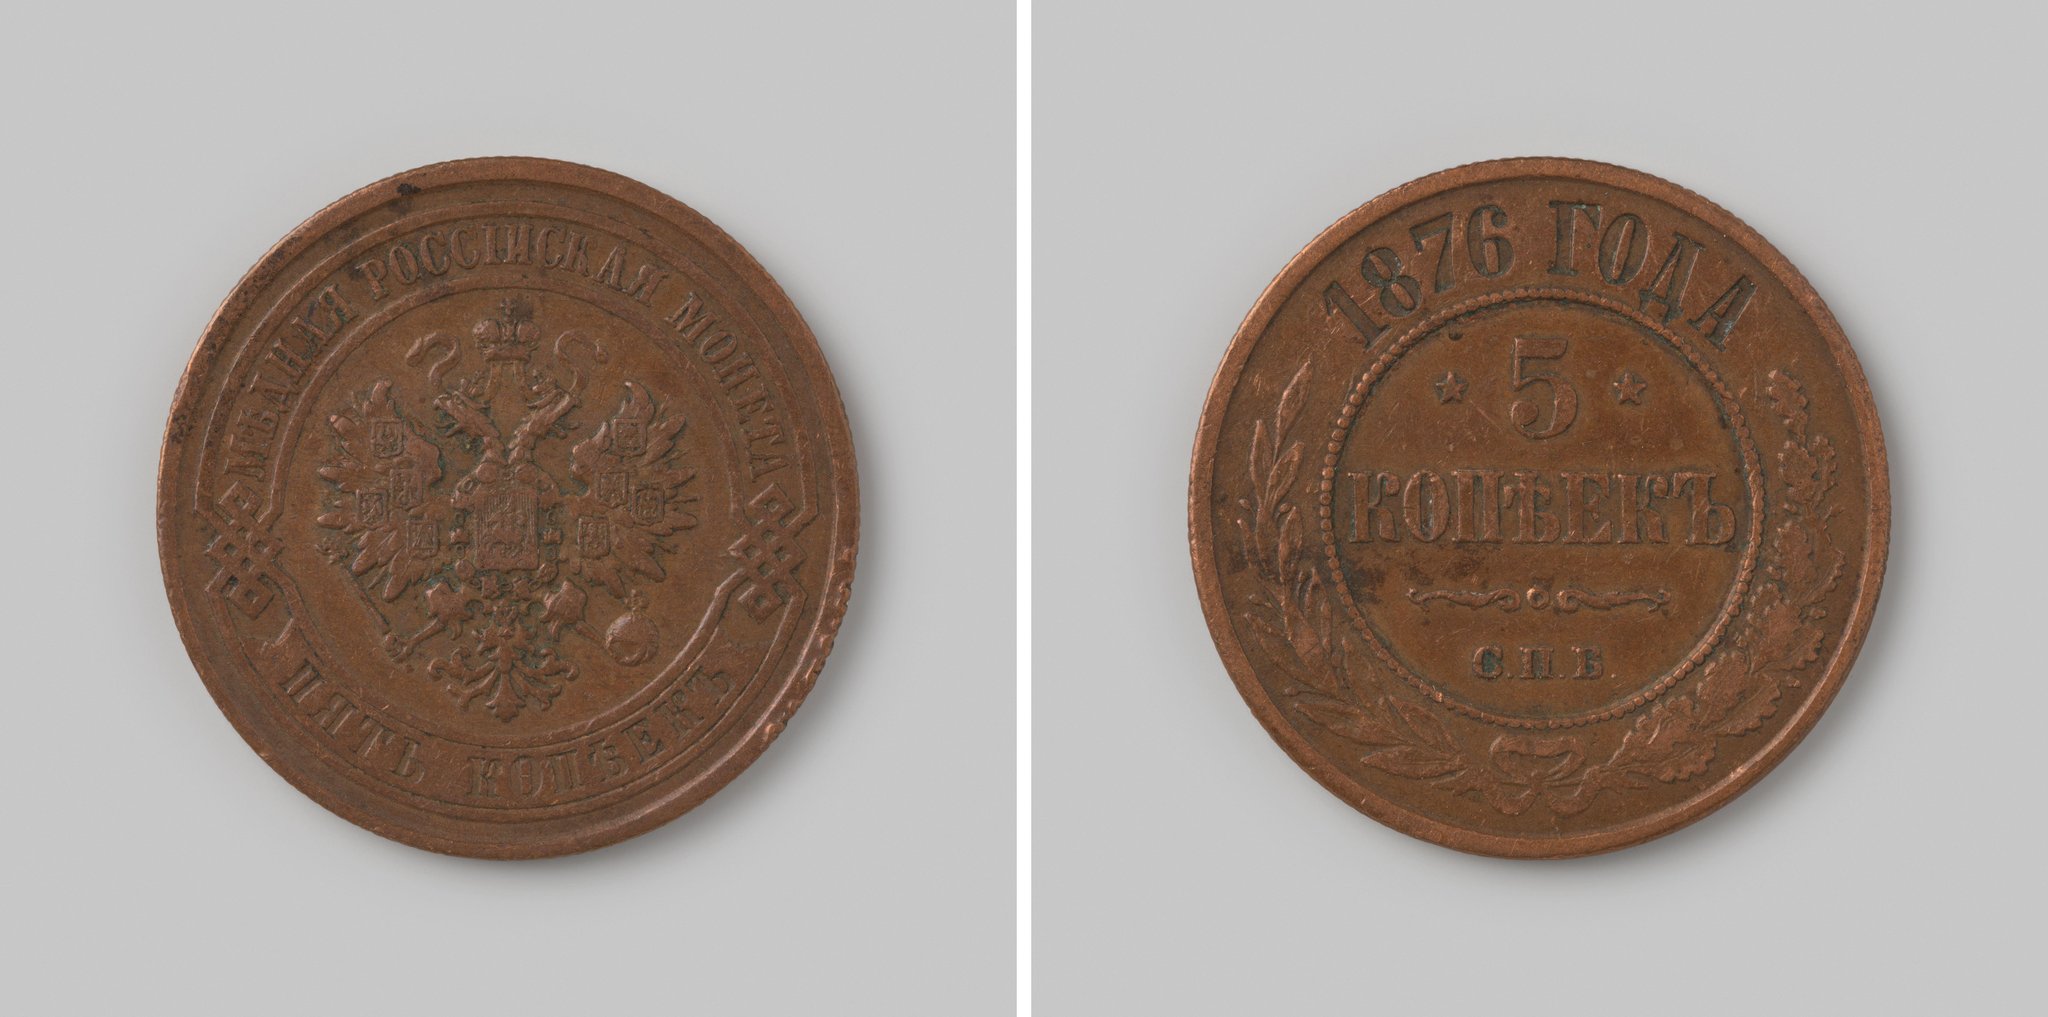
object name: coin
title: Rusland, tsaar Alexander II, 5 kopeken, 1876 SPB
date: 1876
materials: copper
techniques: striking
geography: sint-petersburg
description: Koperen munt. Voorzijde: dubbelkoppige gekroonde adelaar met gespreide vleugels en met op zijn vleugels kleine wapenschilden en op zijn borst een groot, met een ridderorde omhangen wapenschild en in zijn poten een scepter en een gekroonde bol. Boven de adelaar een kroon met lint. Waarde-aanduiding in omschrift onderaan. Keerzijde: tussen twee samengebonden takken in twee regels waarde-aanduiding. Daaronder in het Cyrillisch de letters S,P en B [=Sint Petersburg]. Jaartal bovenaan in omschrift. Kartelrand.